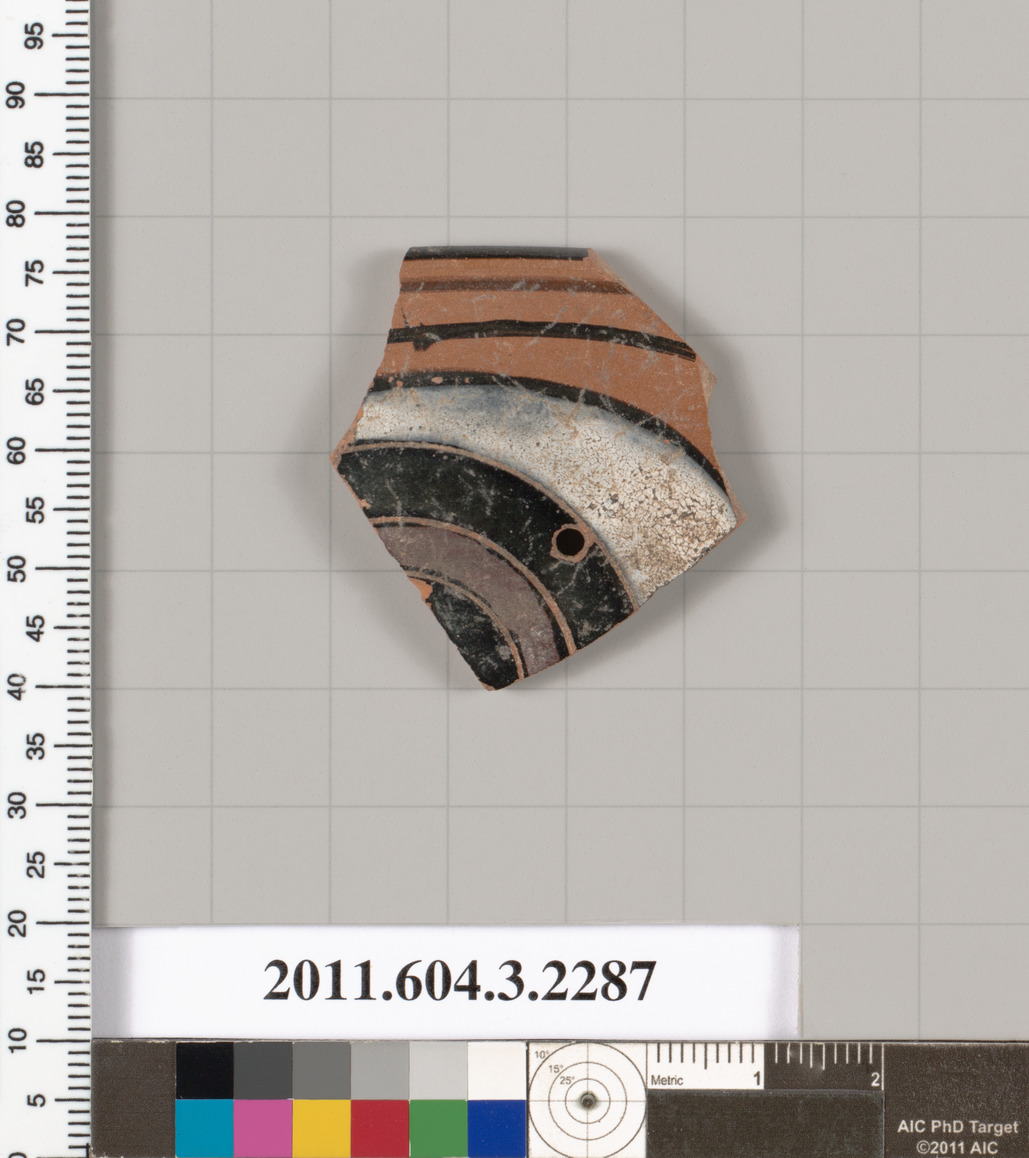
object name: kylix fragment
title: Terracotta rim fragment of a kylix: eye-cup (drinking cup)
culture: greek, attic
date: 530-510 BCE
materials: terracotta